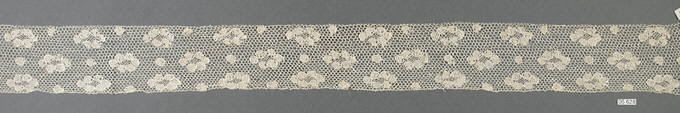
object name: insertion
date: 1800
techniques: lace